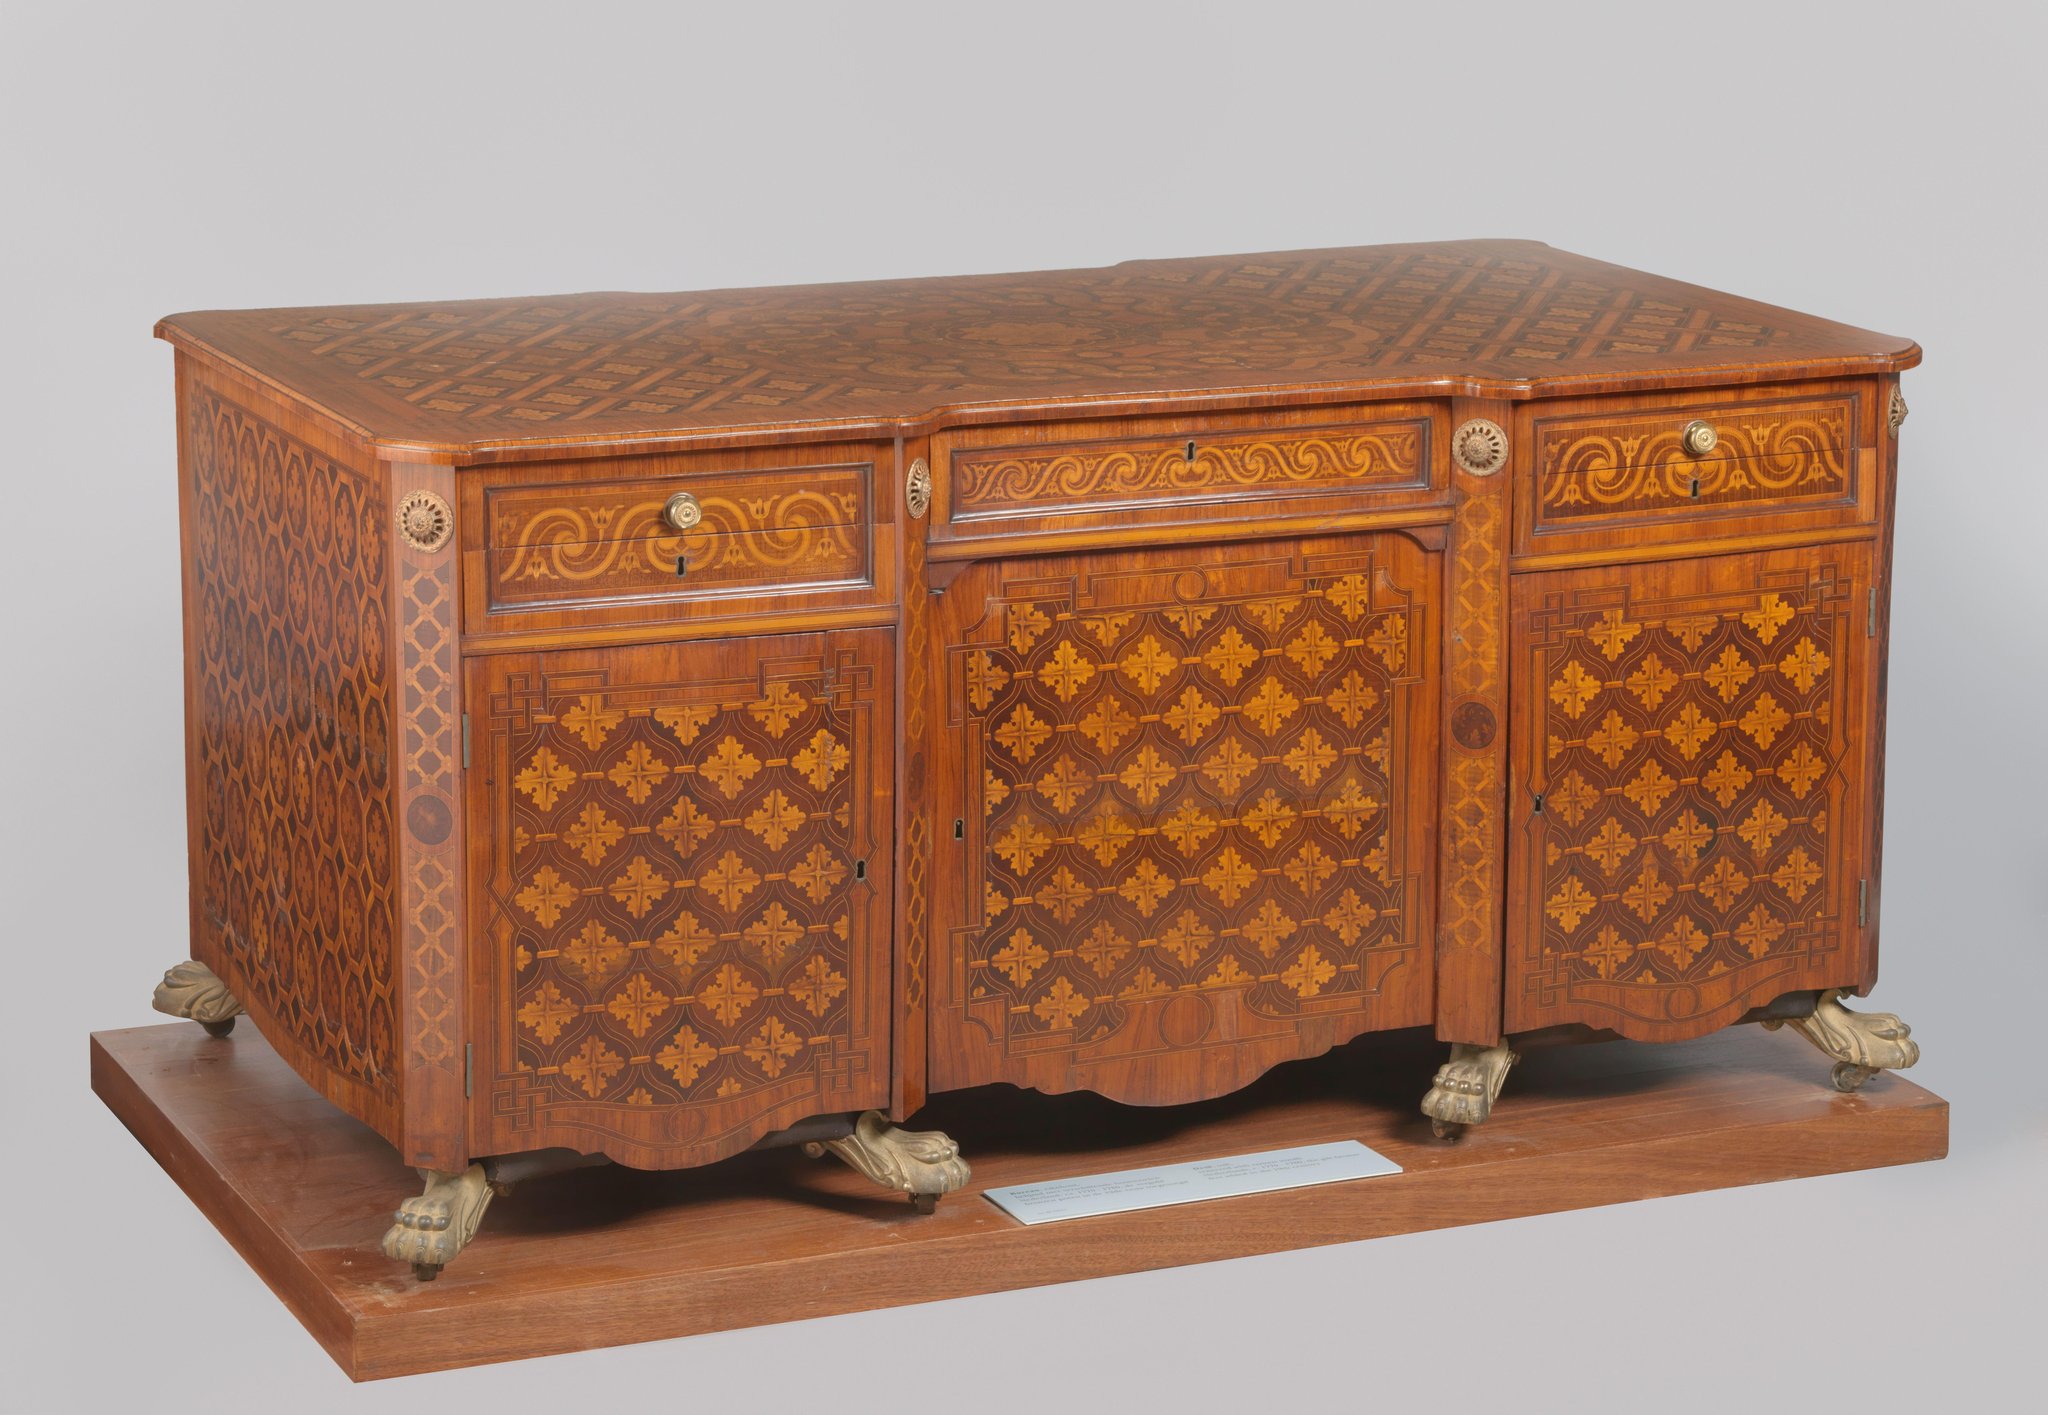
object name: bureau table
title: Bureau, driedelig, met terugwijkend middendeel, geaccentueerd door schuingeplaatste stijlen met bronzen leeuwenklauwen. Belijmd met meerdere houtsoorten.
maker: Anonymous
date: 1750-1800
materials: bronze, copper, wood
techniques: gilding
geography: northern netherlands